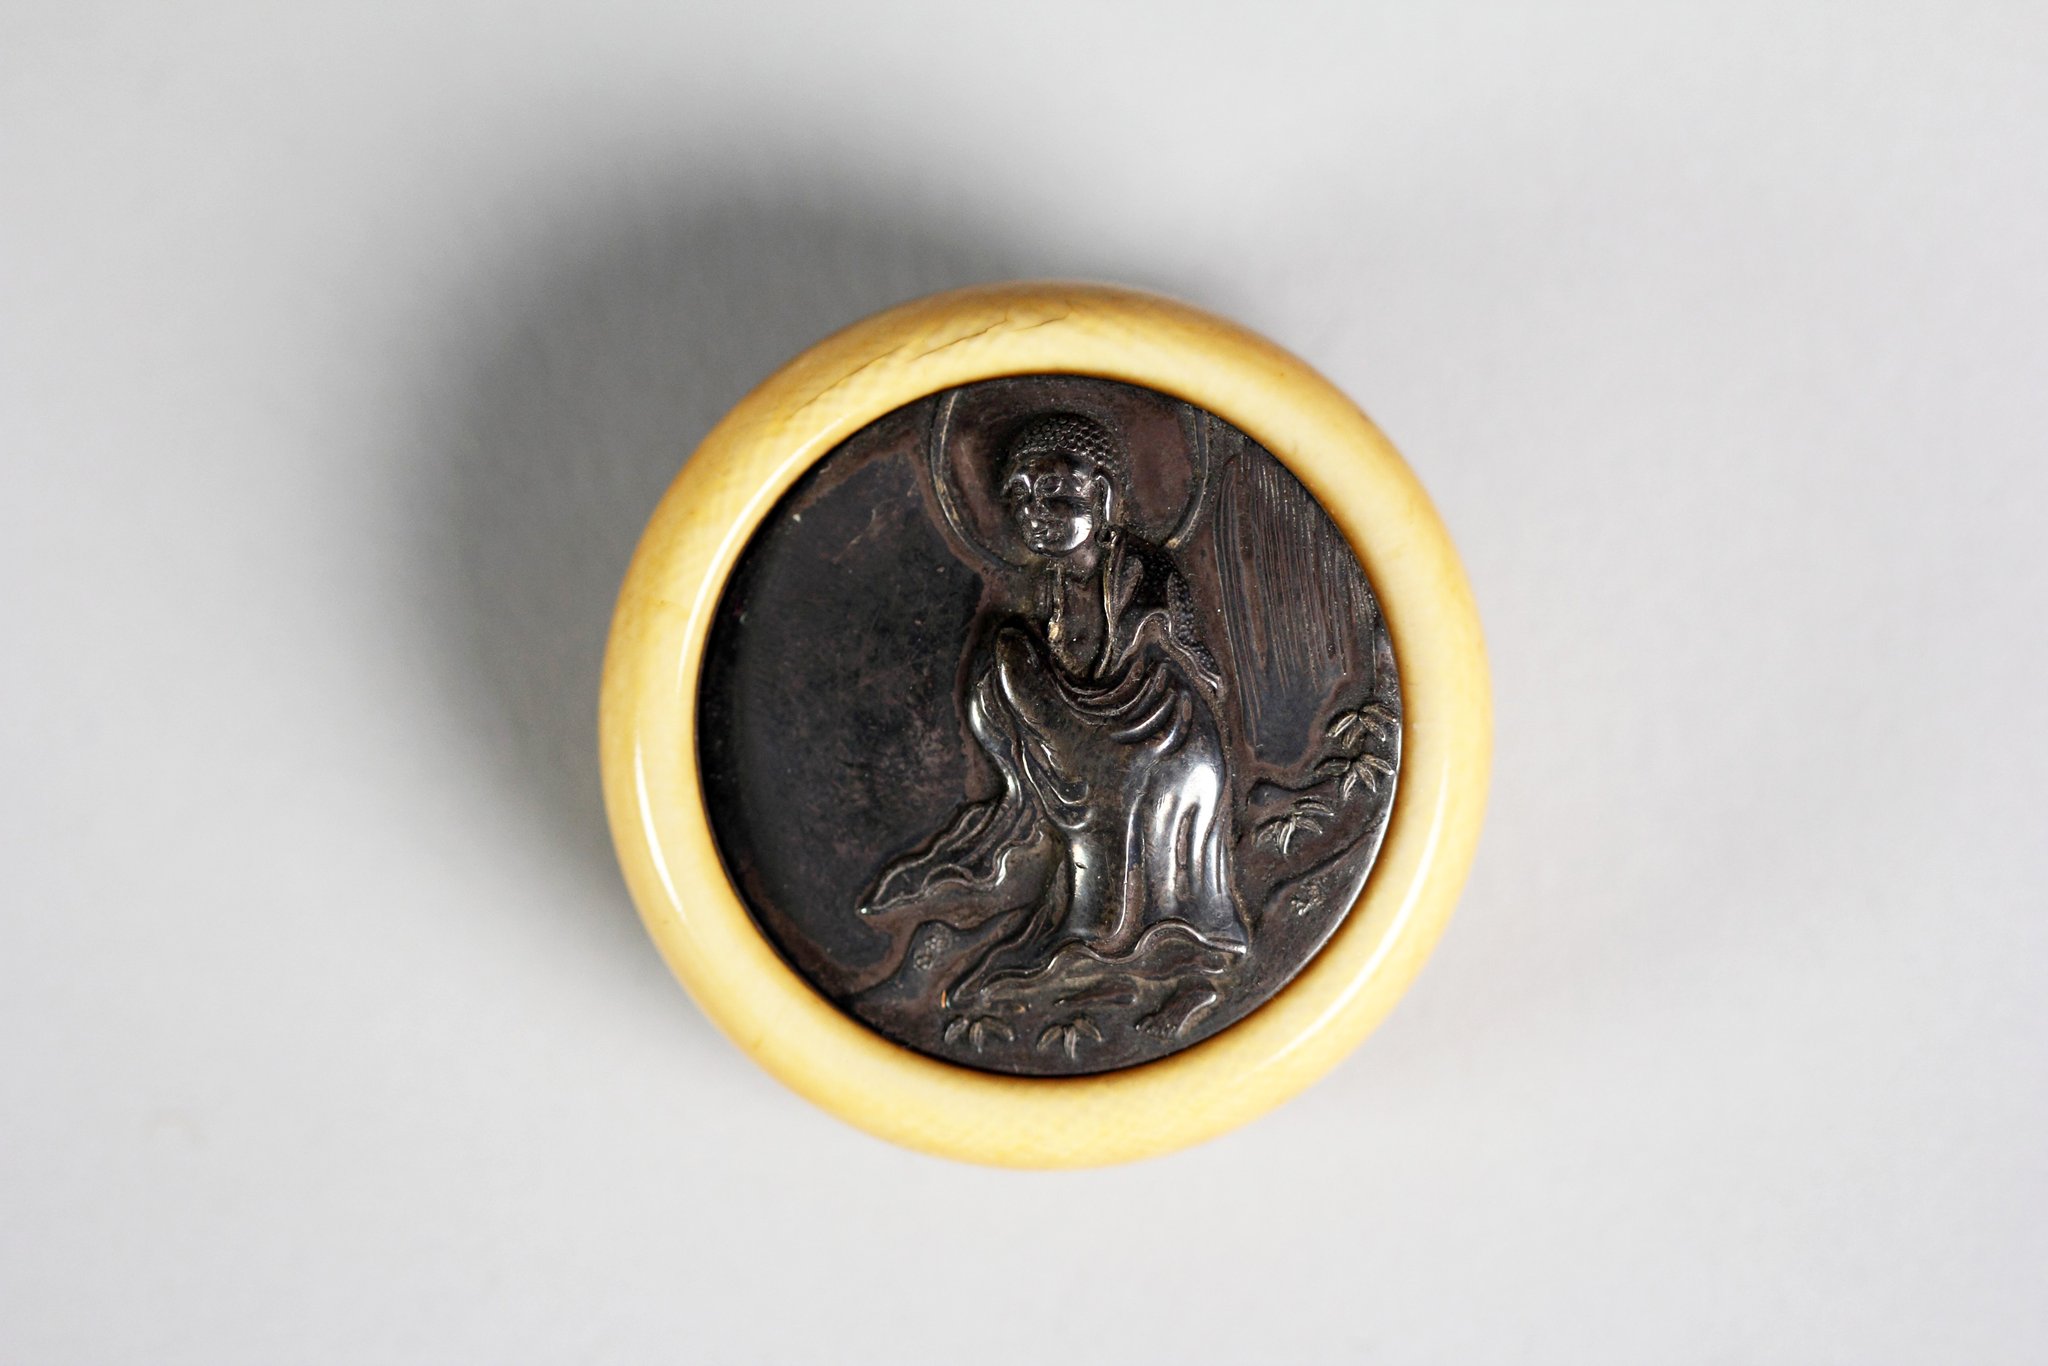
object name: netsuke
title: Netsuke of Shakyamuni Buddha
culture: japanese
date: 1801-1900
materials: bronze, ivory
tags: buddha,shakyamuni